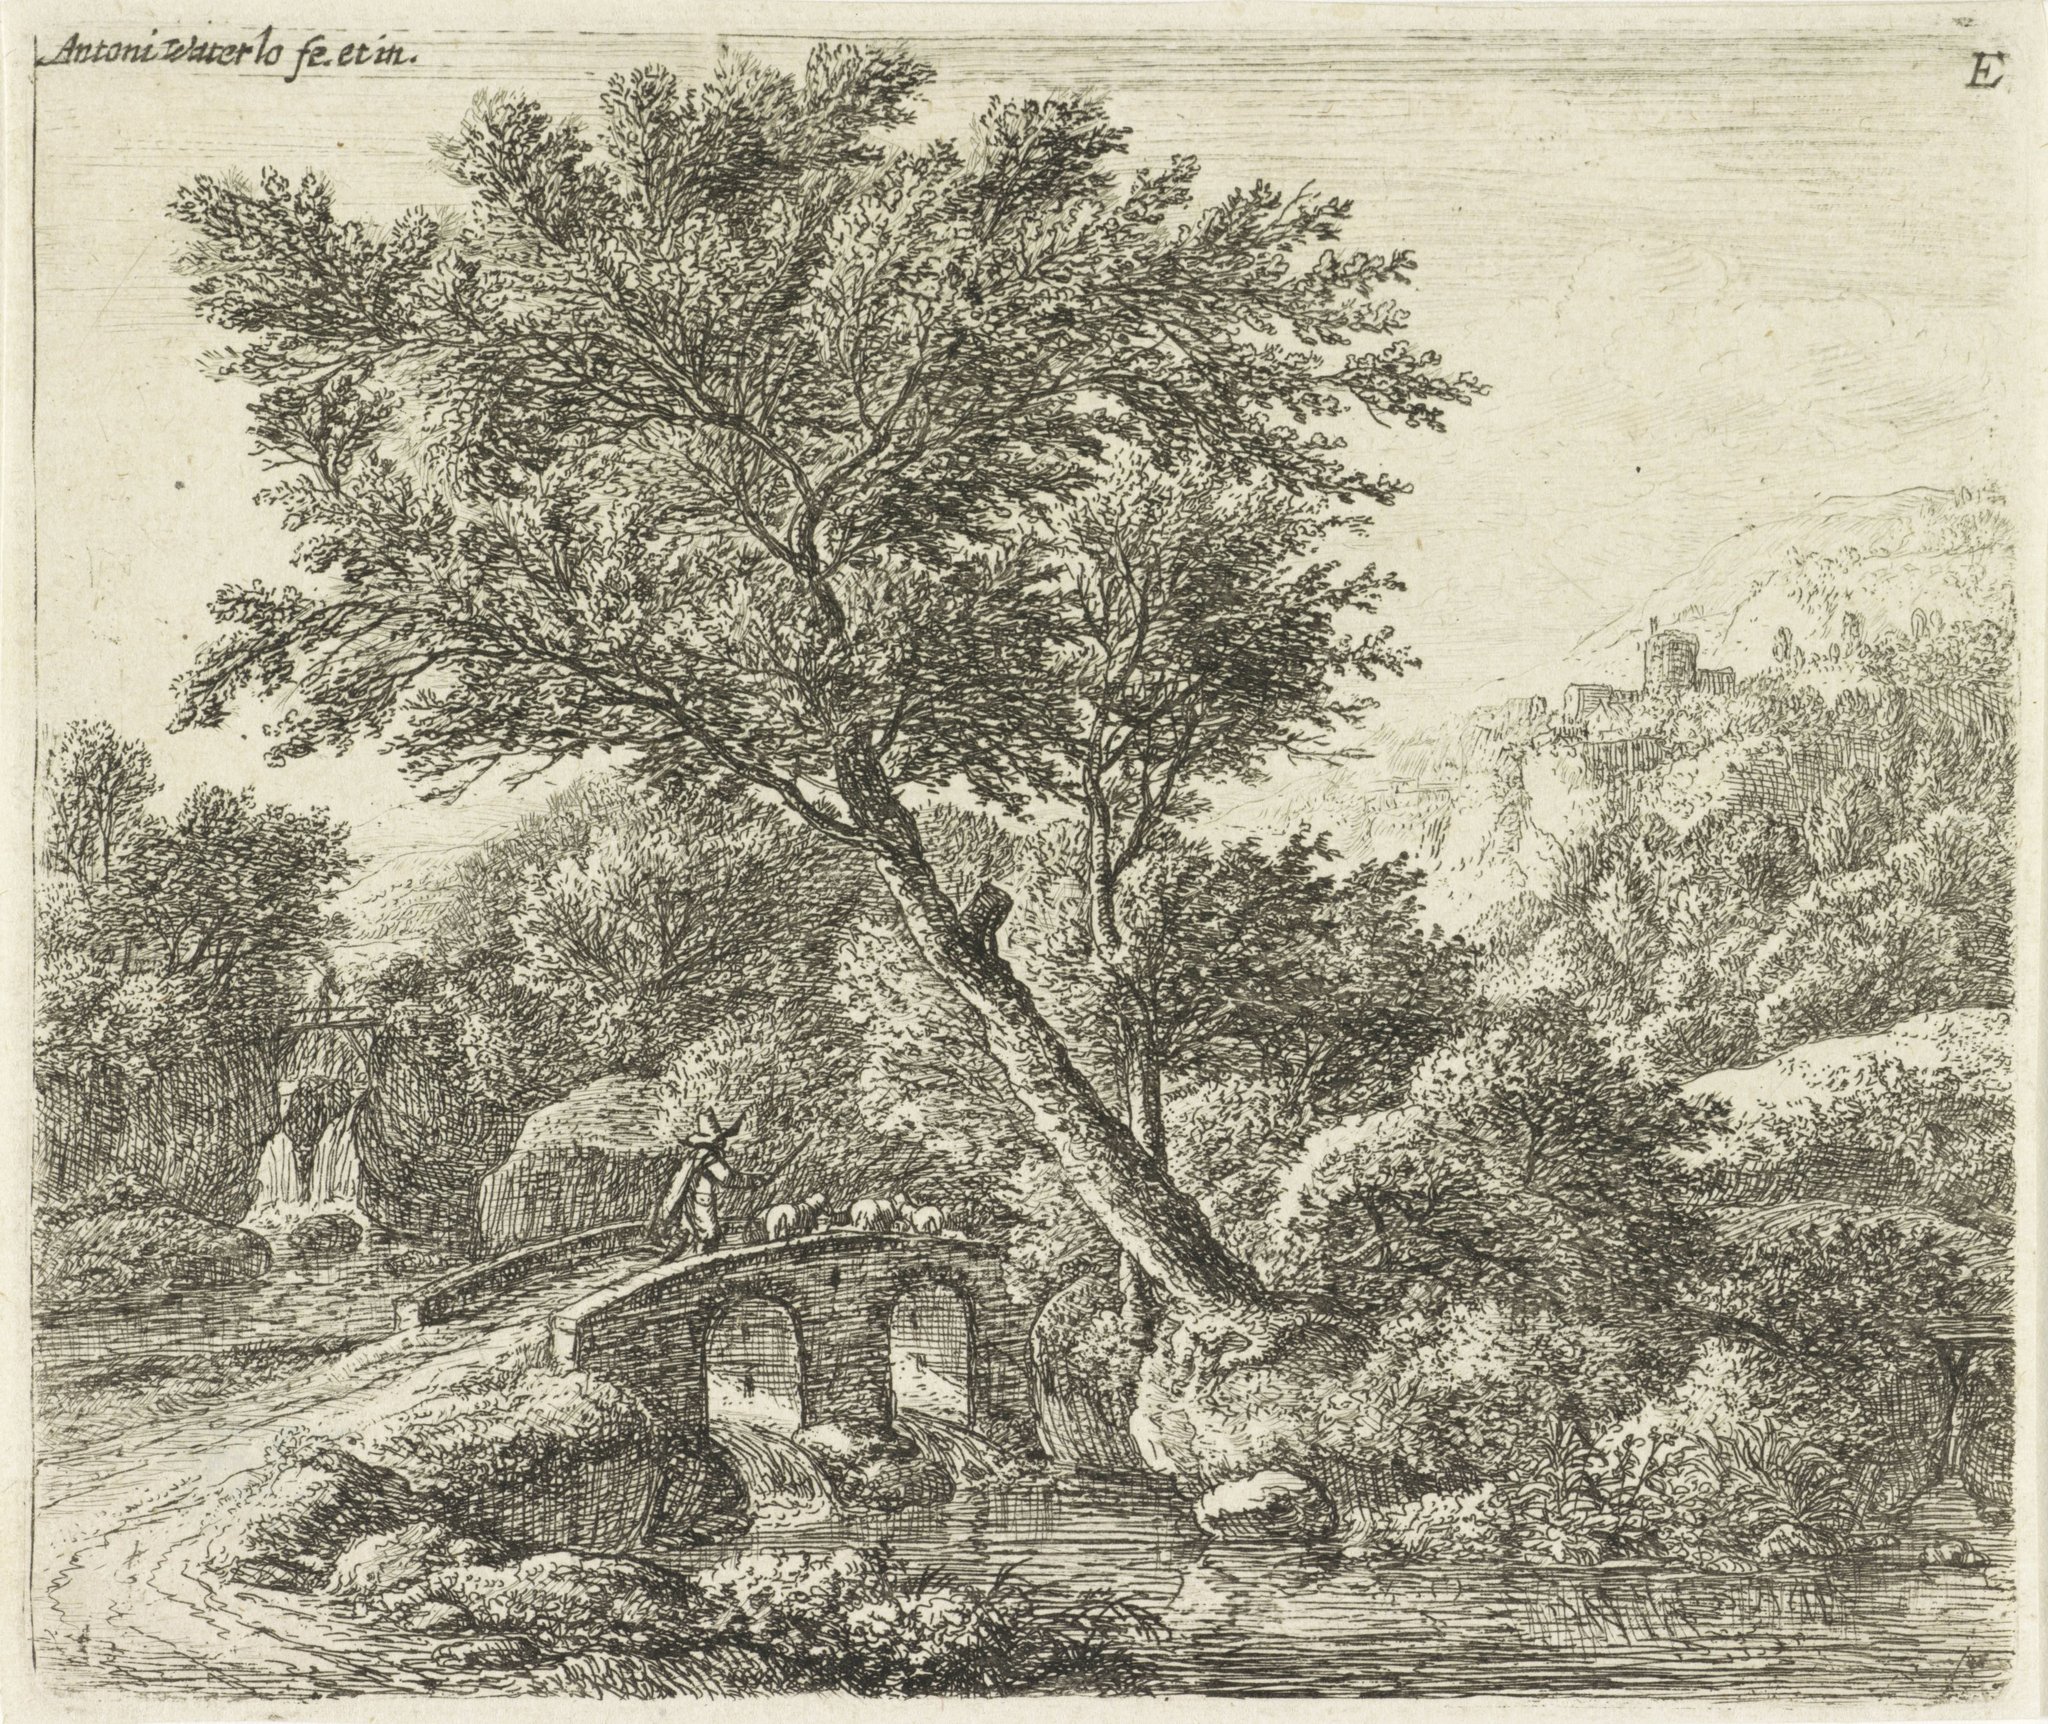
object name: print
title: Herder op een stenen brug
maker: anthonie waterloo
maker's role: draughtsman, painter, print maker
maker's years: 1609-1690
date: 1630-1663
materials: paper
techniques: etching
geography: amsterdam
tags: castle, herding, herdsman, herdswoman, shepherd, shepherdess, cowherd, etc., waterfall, forest, wood, bridge, mountains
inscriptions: collector's mark: Lugt 2165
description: Links loopt een herder met zijn kudde over een stenen boogbrug. Links in de verte stroomt een waterval. Rechts in de verte ligt een burcht op een met bomen begroeide berg. Rechtsboven is de letter E te zien.